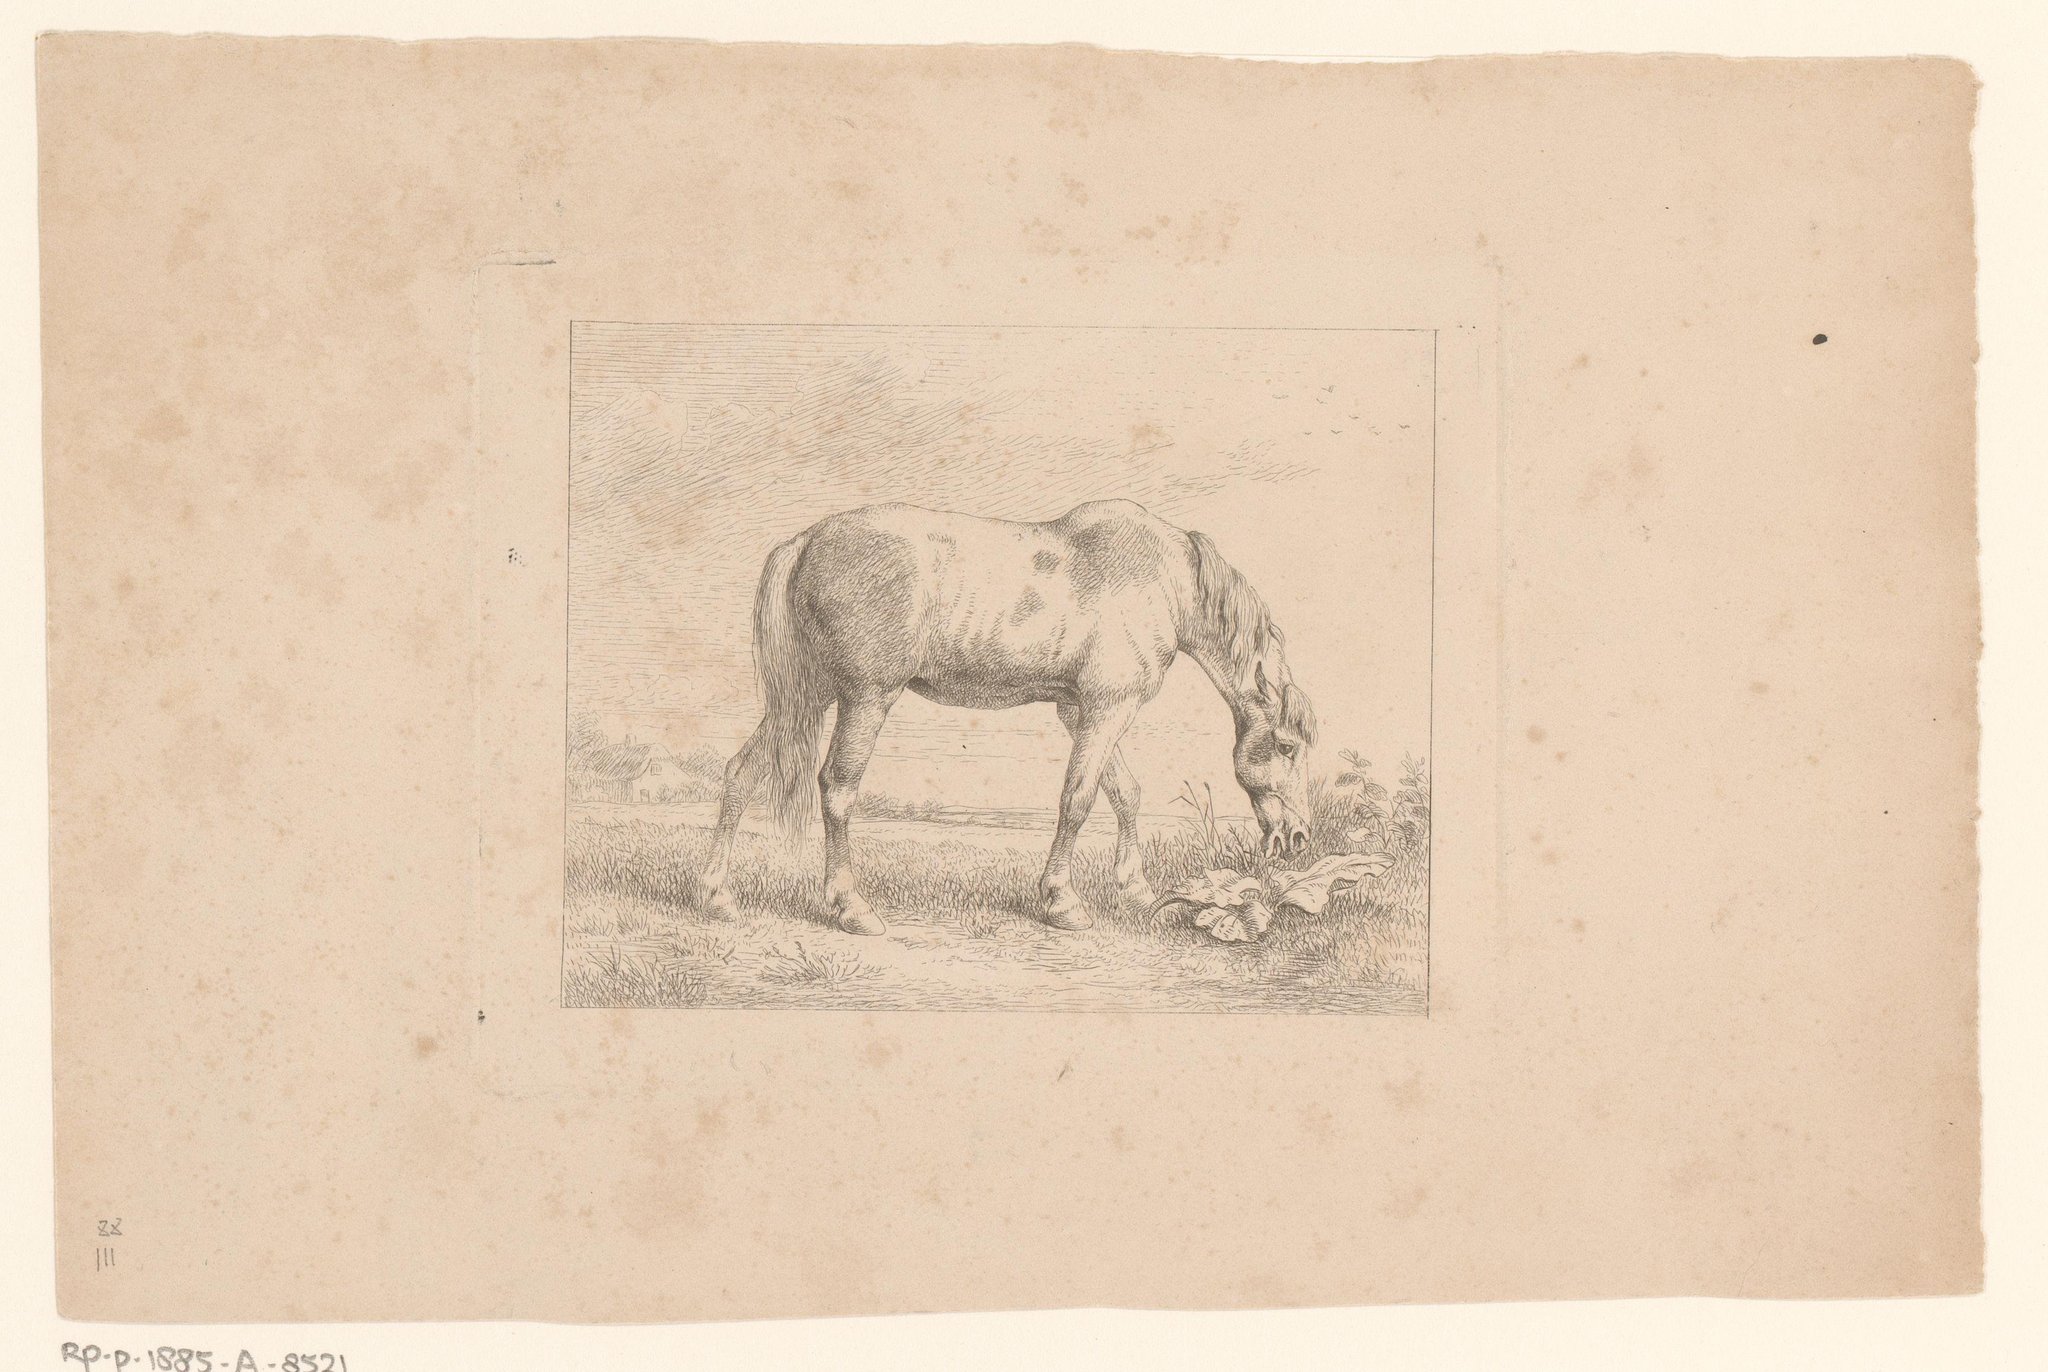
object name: print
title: Grazend bont paard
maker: charles tschaggeny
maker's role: print maker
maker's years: 1815-1894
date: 1825-1885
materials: paper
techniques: etching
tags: horse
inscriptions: collector's mark: Lugt 2228